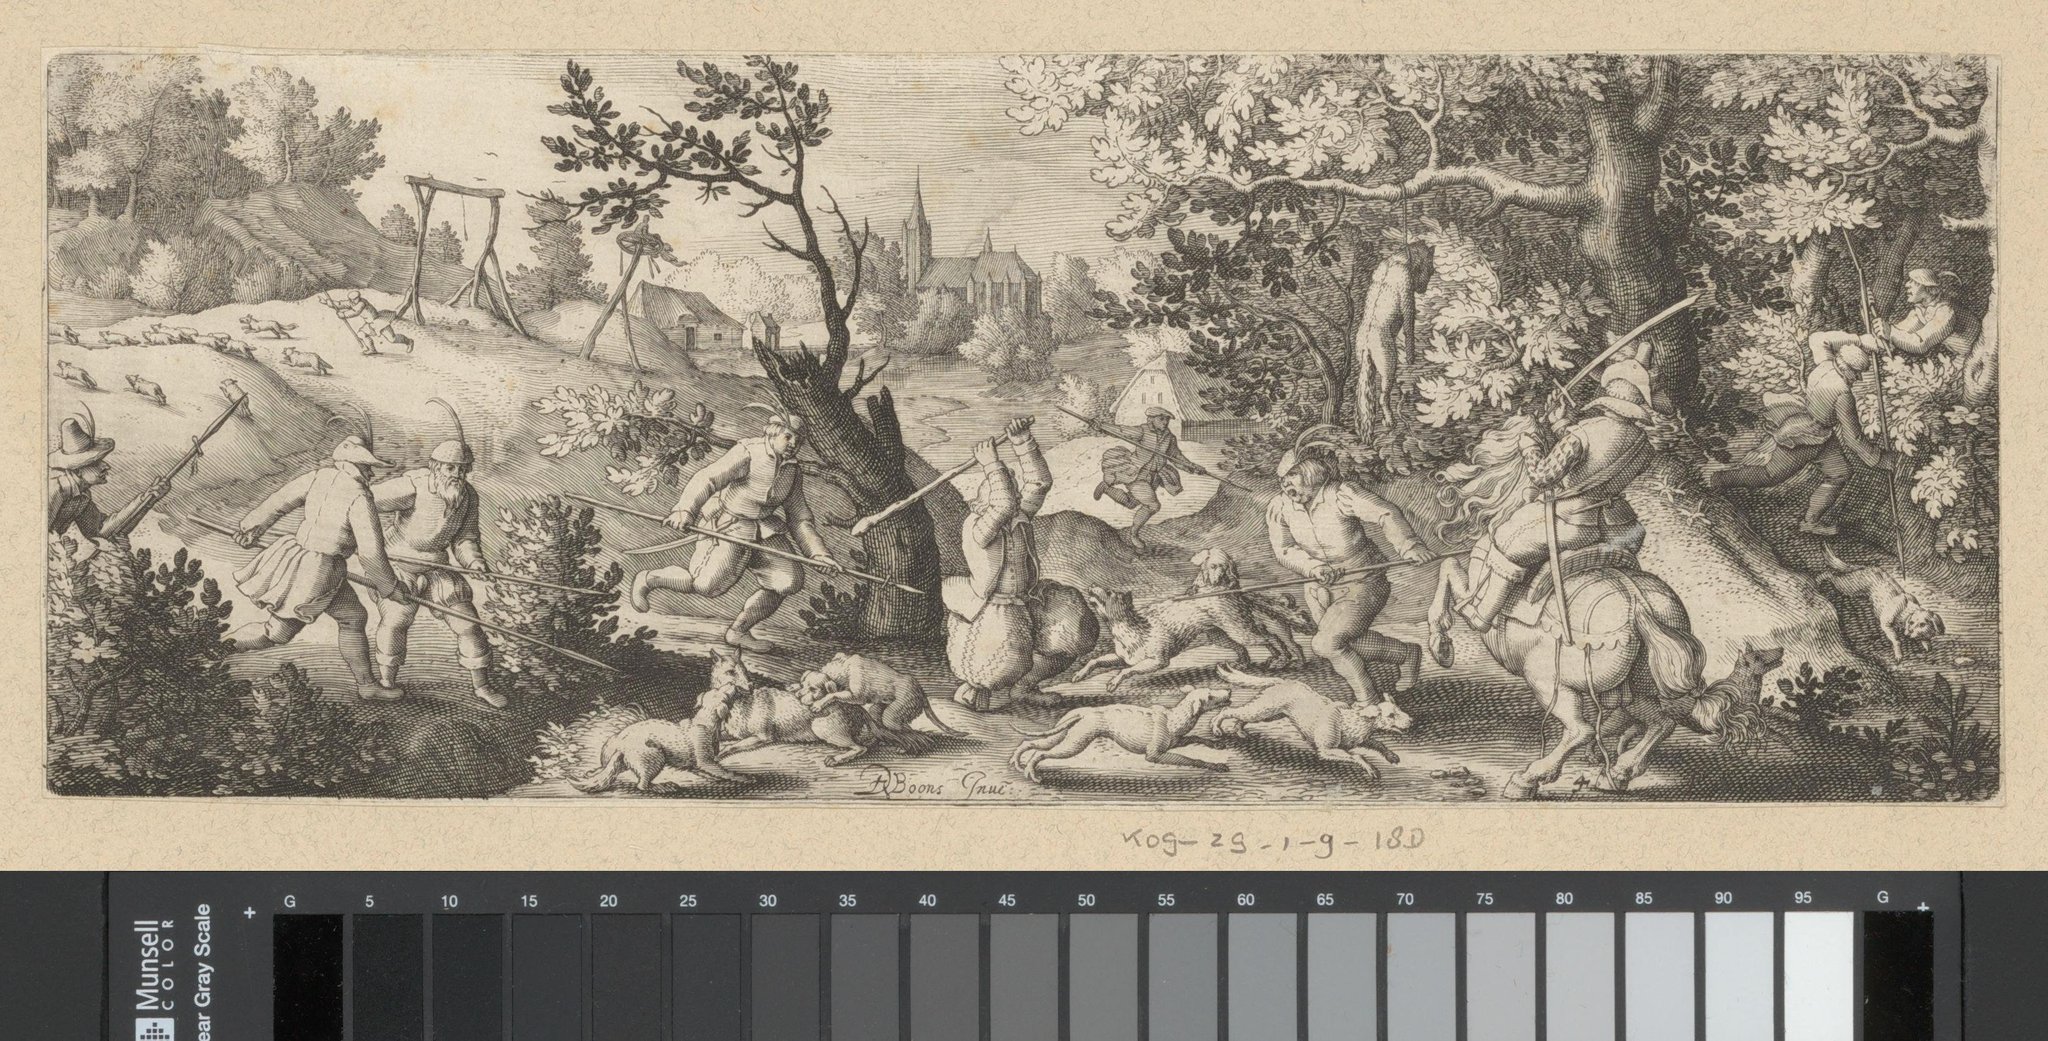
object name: print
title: Vossenjacht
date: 1612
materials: paper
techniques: engraving, etching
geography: amsterdam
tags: fox hunting, casting weapons: spear, the kill (~ hunting)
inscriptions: collector's mark: Lugt 1641, stamp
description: Mannen te voet en te paard jagen op vossen. Aan een tak hangt een vos. Onderwerpsrubrieken binnen de Atlas Zeden en Gewoonten: Handel, nijverheid en verkeer, jacht.